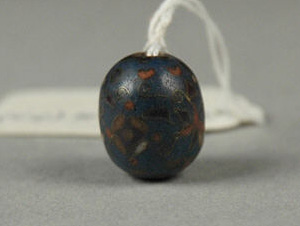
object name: ojime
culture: japanese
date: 1801-1900